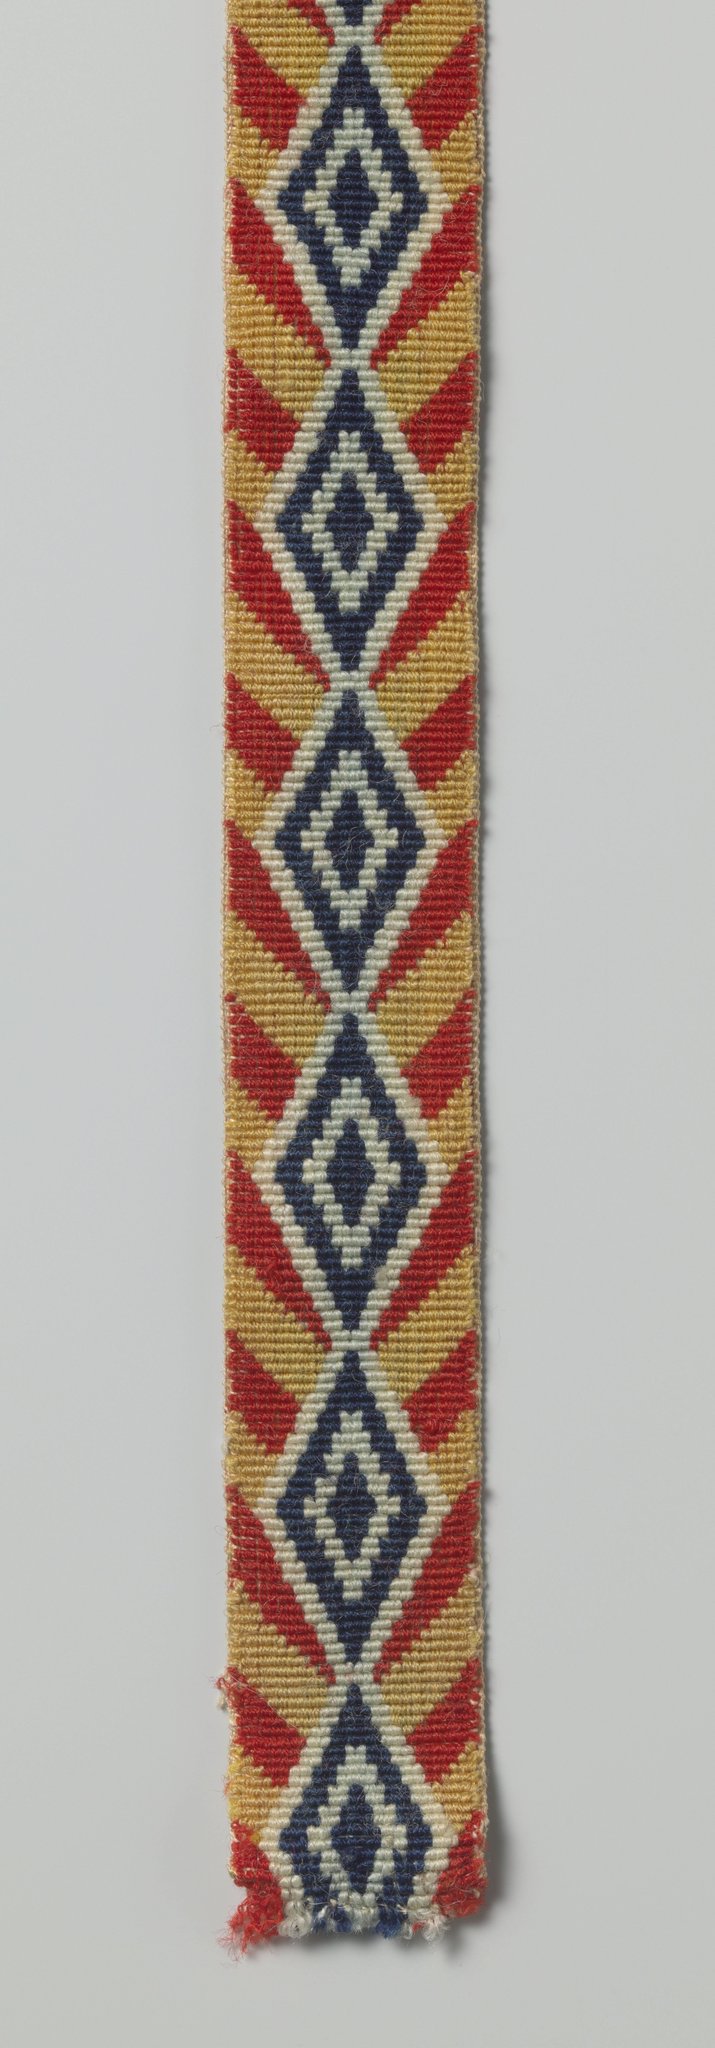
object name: passementerie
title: Metrage livreiband in passementweefsel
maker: Anonymous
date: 1700-1799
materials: silk, wool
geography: netherlands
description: Metrage livreiband in passementweefsel in de kleuren van de familie Teding van Berkhout, uitgevoerd in zijde en wol.